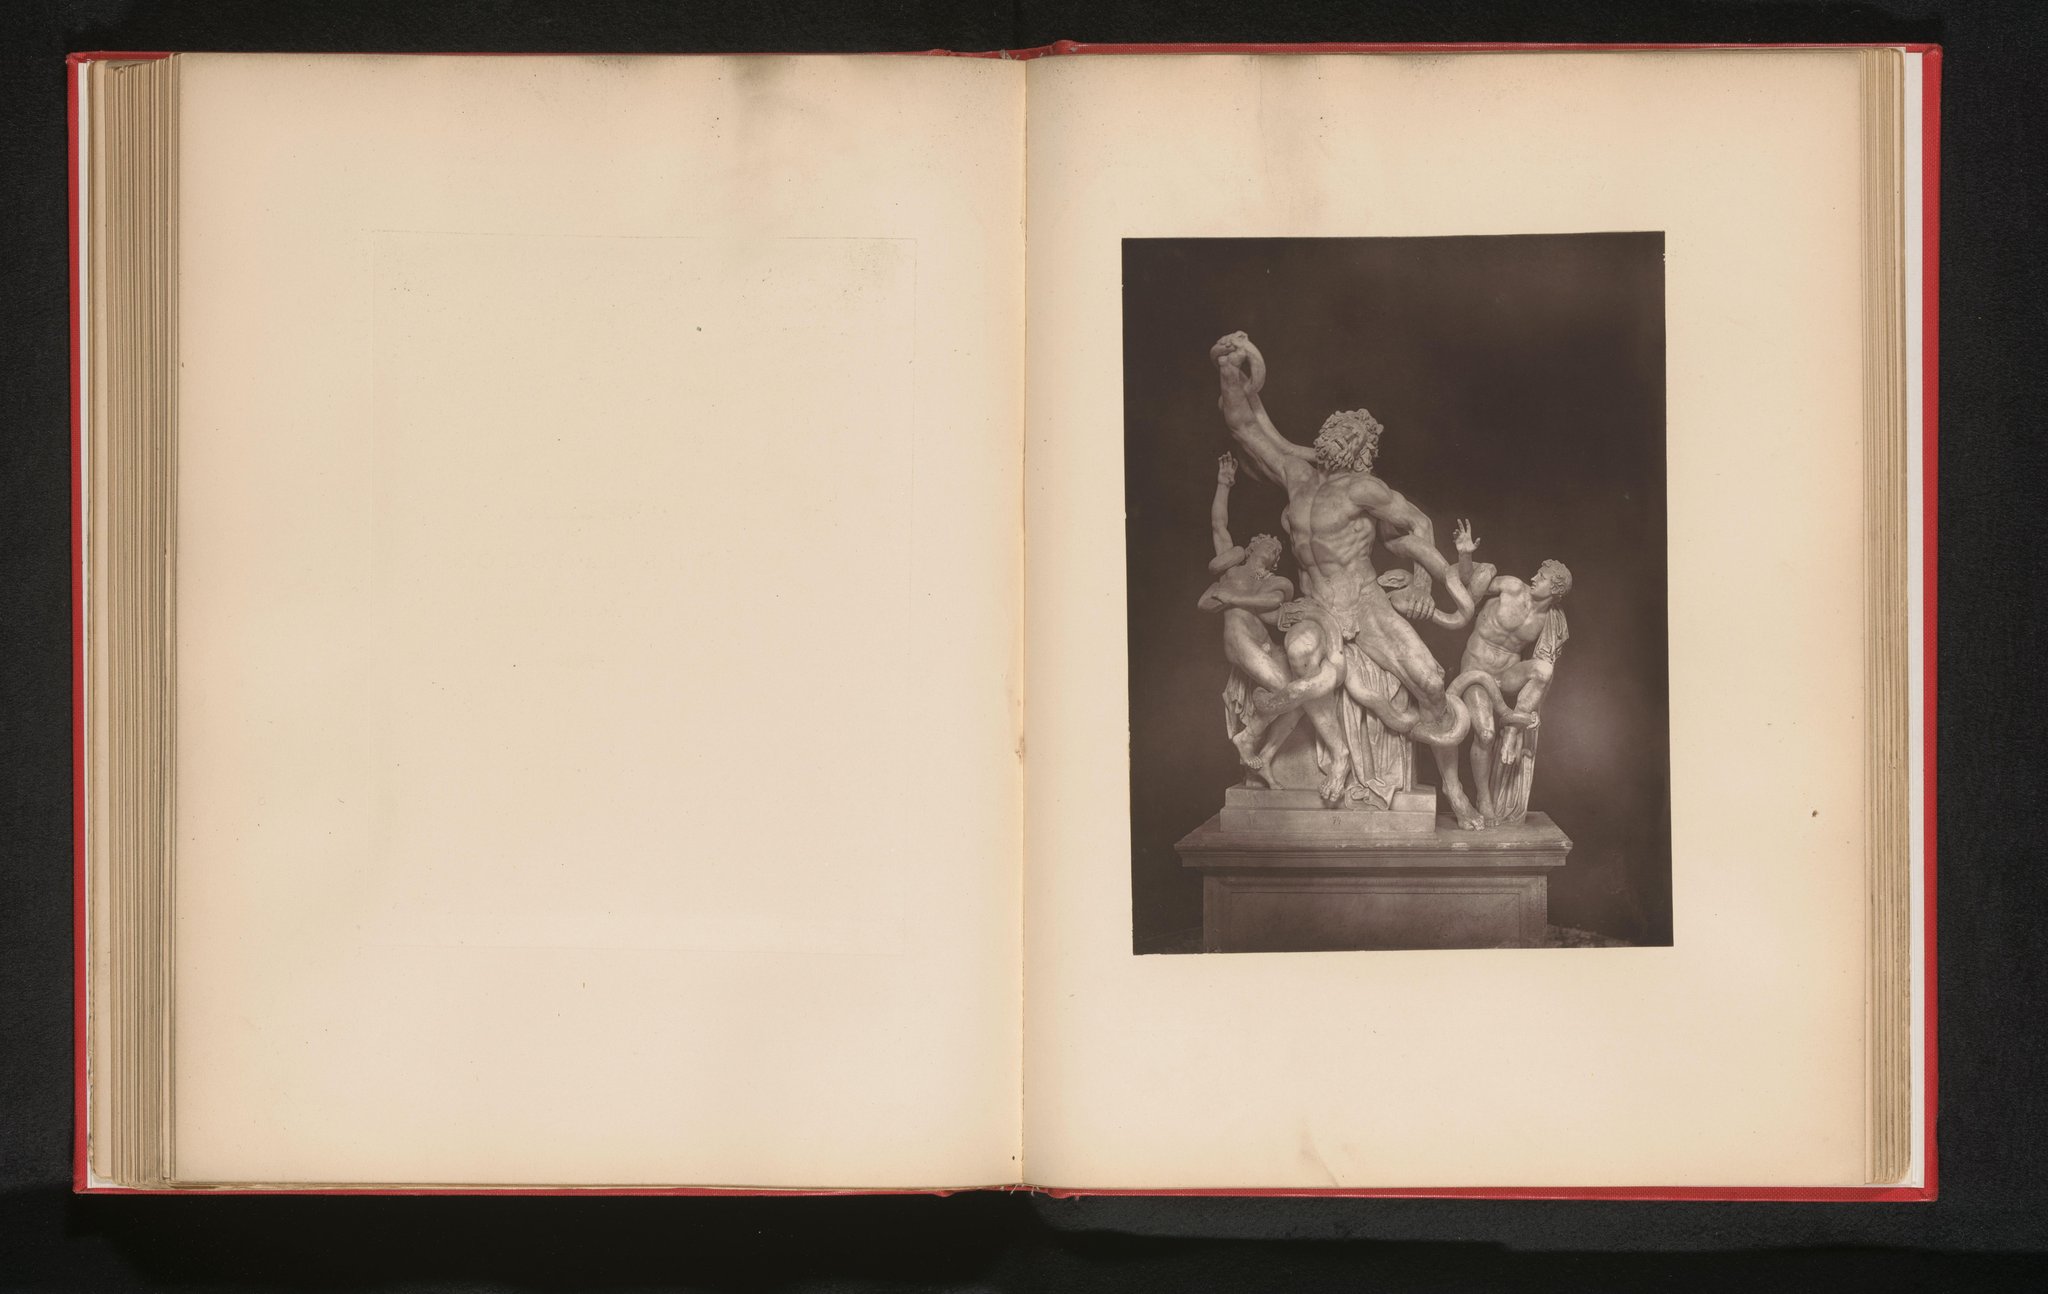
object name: page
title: Beeldhouwwerk Laocoöngroep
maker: stephen thompson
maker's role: fotograaf, schrijver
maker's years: 1831-1893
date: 1873-1878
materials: paper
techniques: woodburytype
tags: laocoon and his twin sons are strangled by two serpents during the preparations for a sacrifice, sculpture